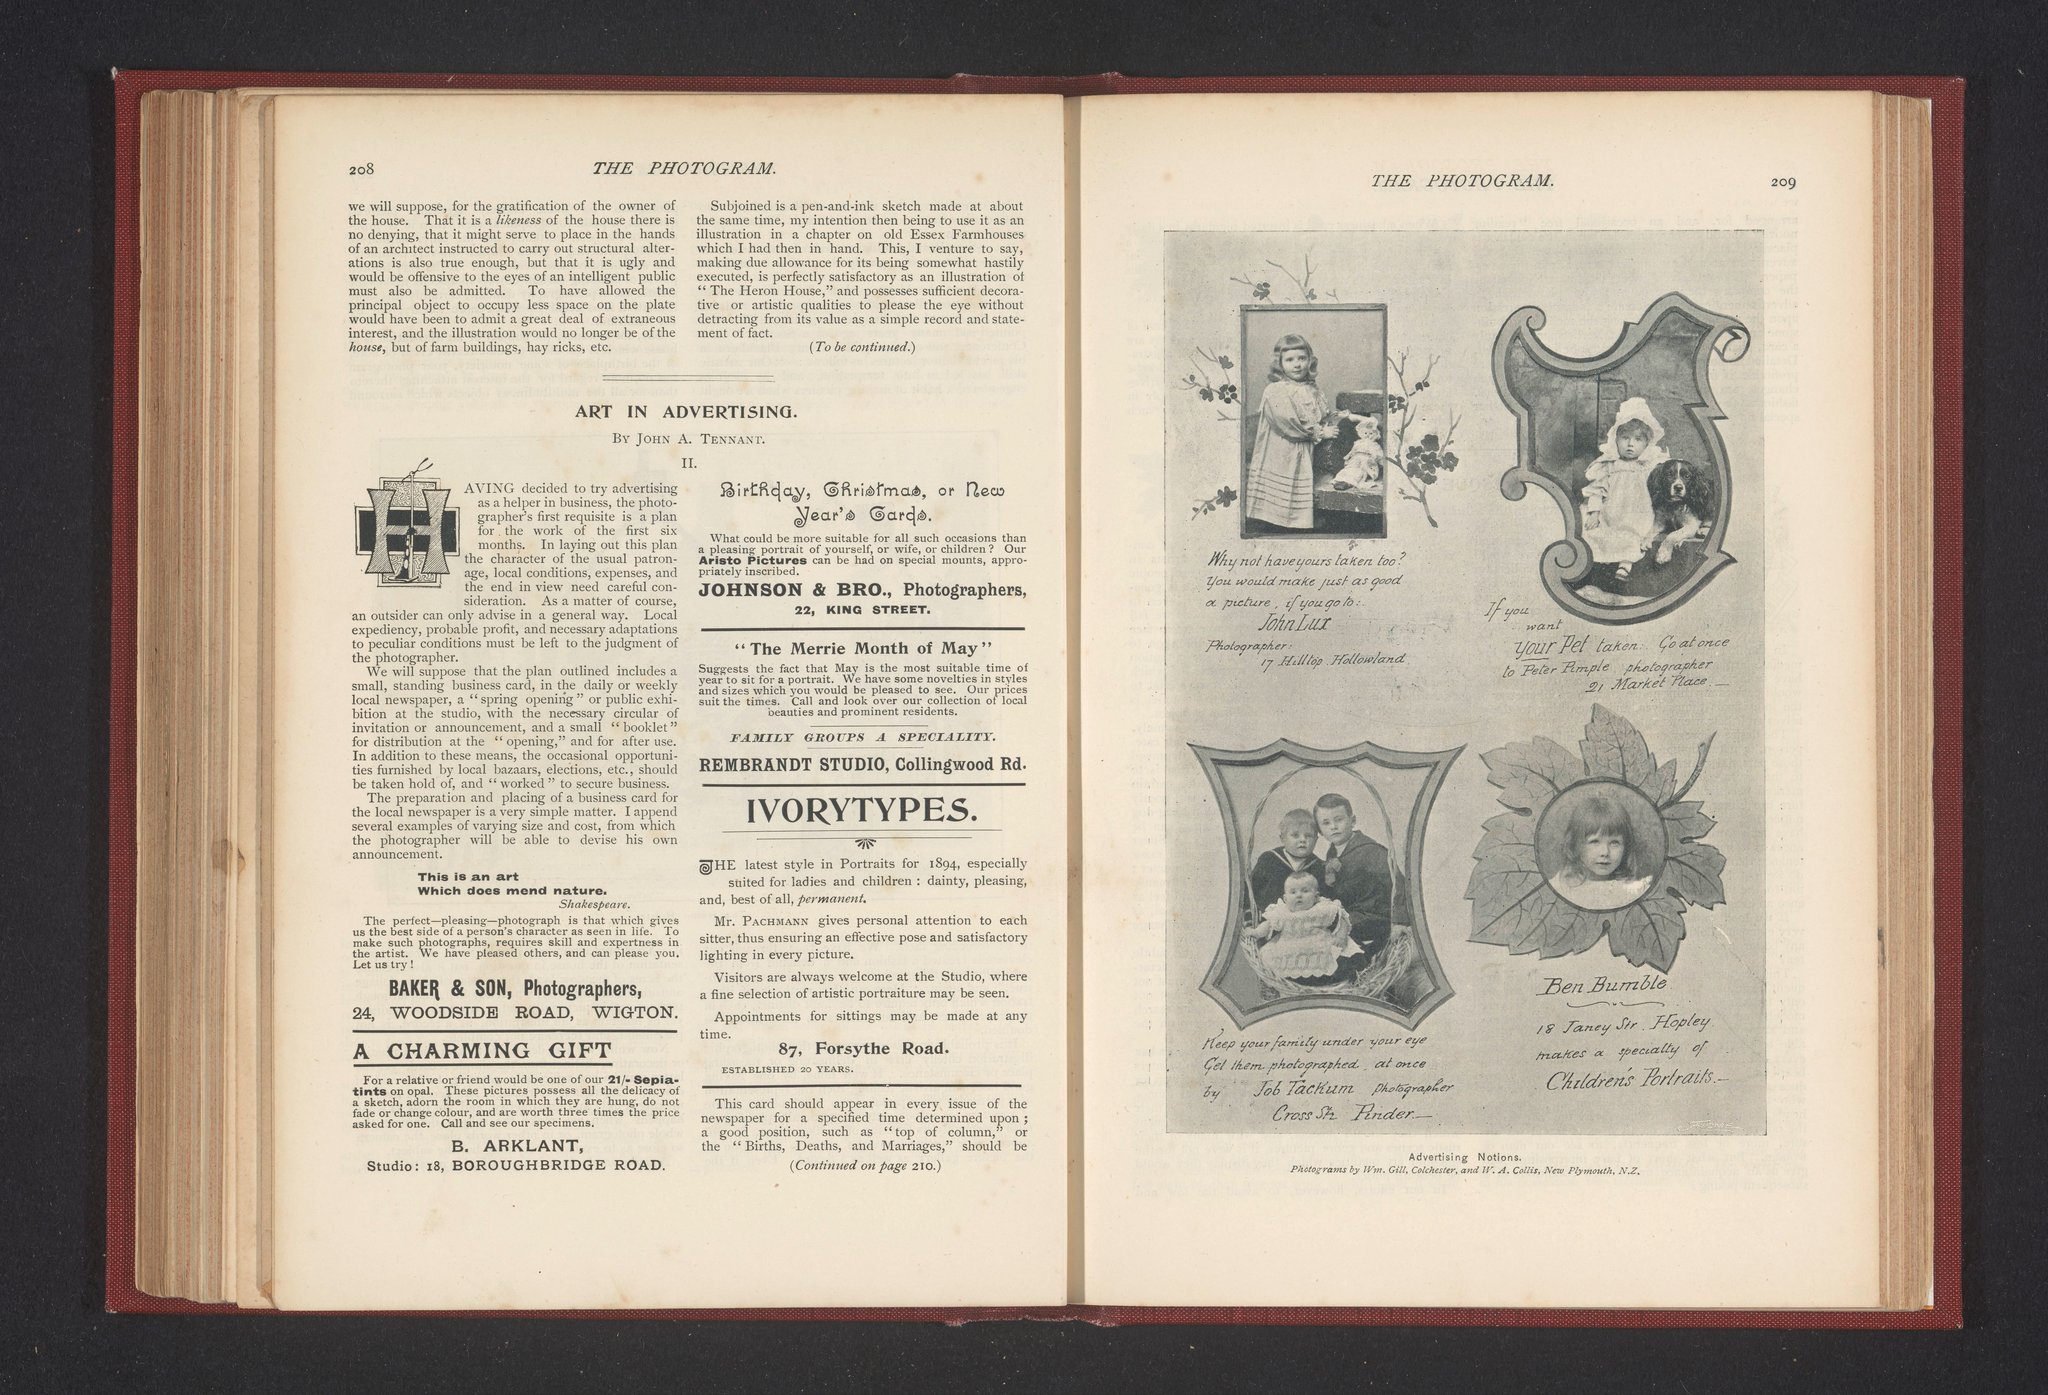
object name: page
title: Advertising Notions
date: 1889-1894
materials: paper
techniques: autotype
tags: advertisement, notice